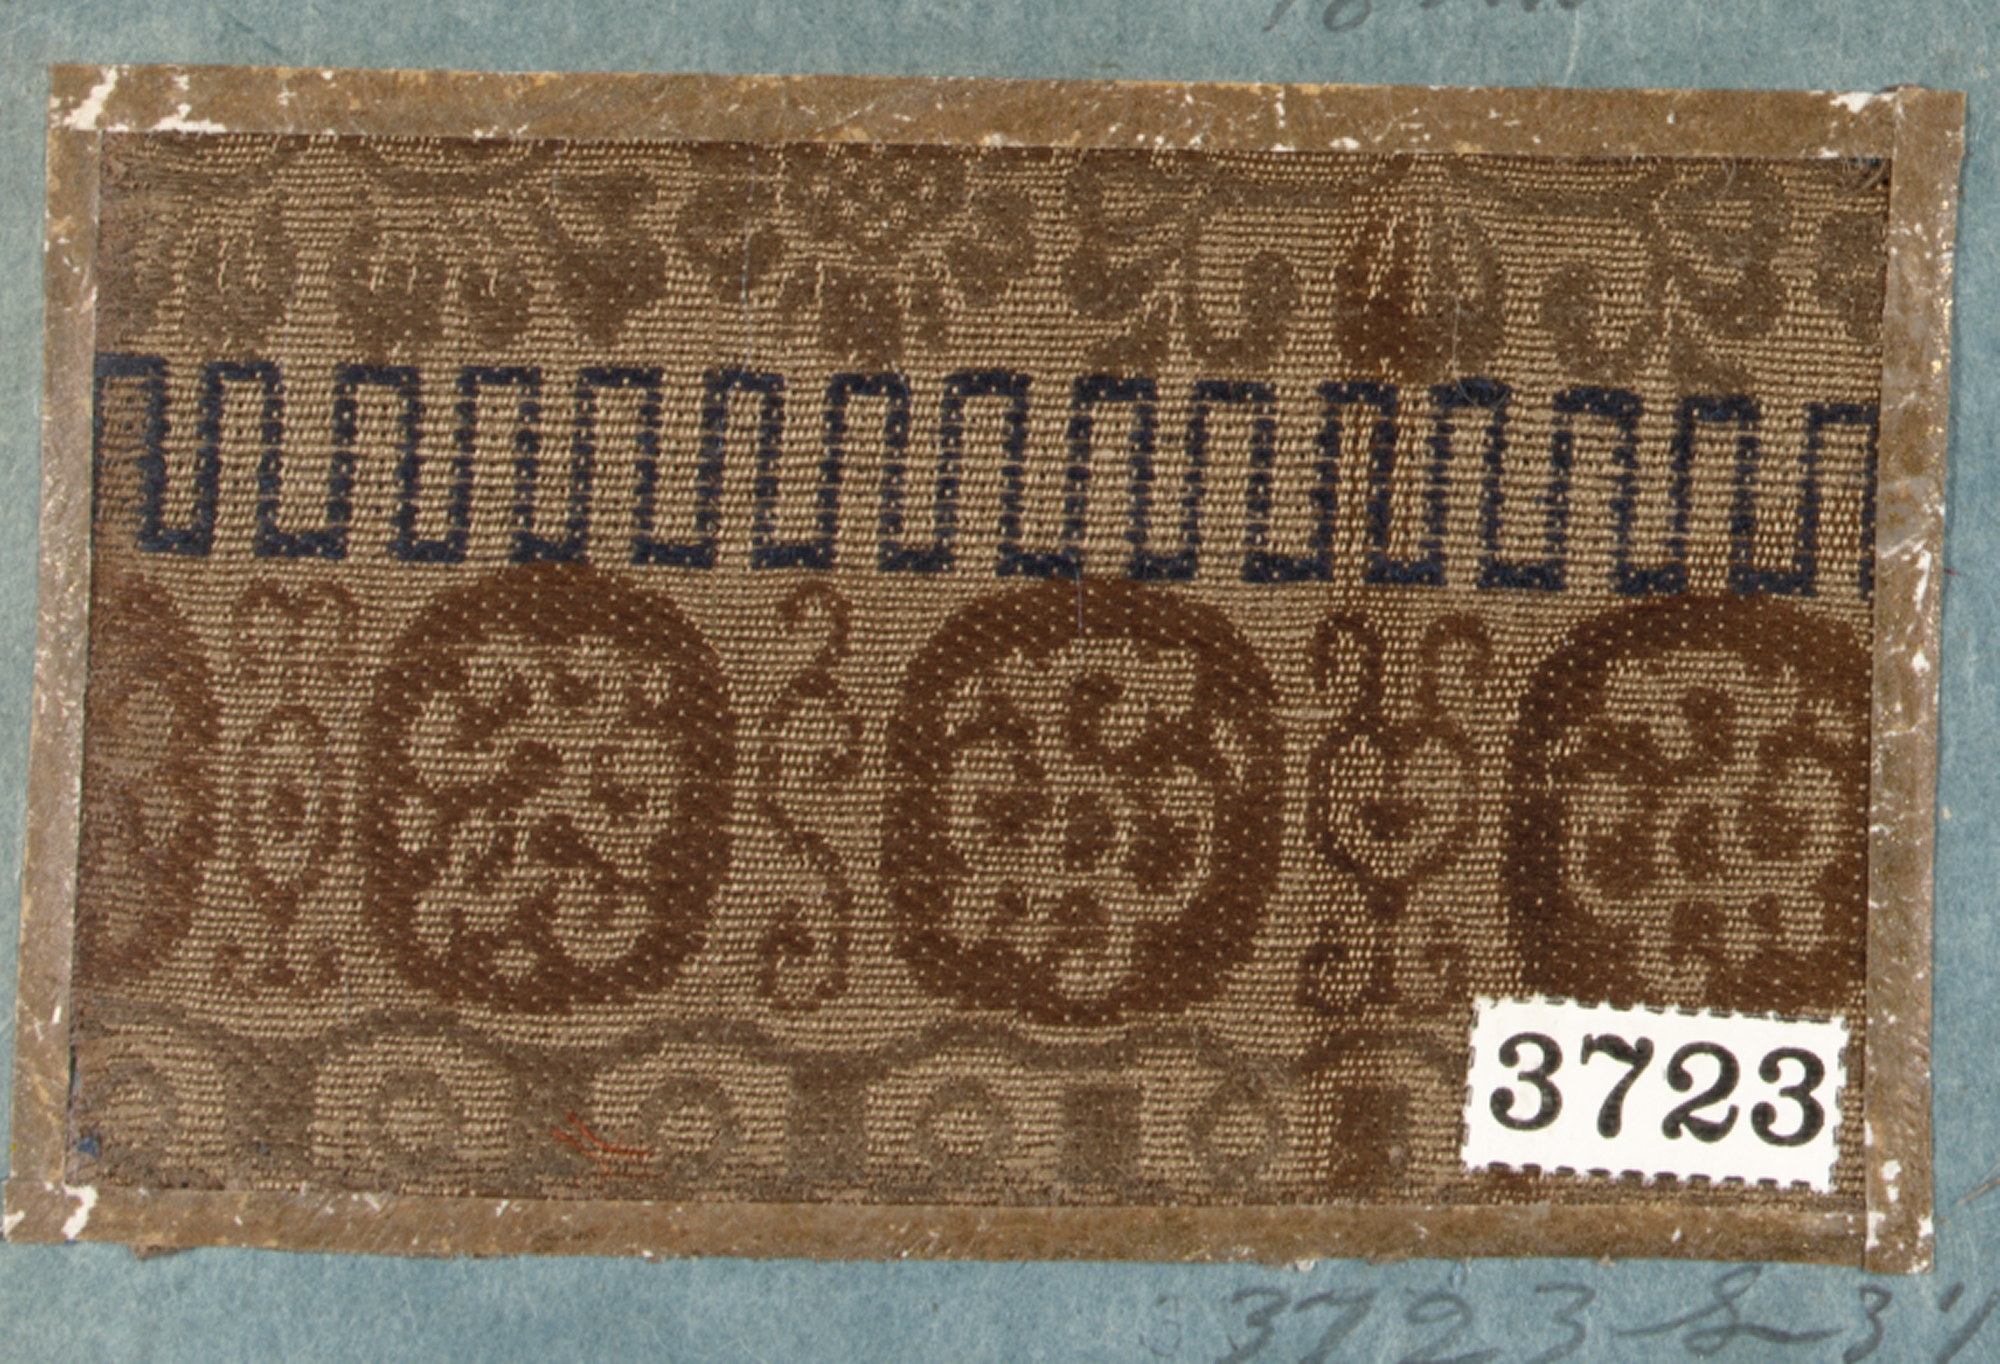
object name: sample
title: Textile Sample from Sample Book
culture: japanese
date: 1801-1900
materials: silk